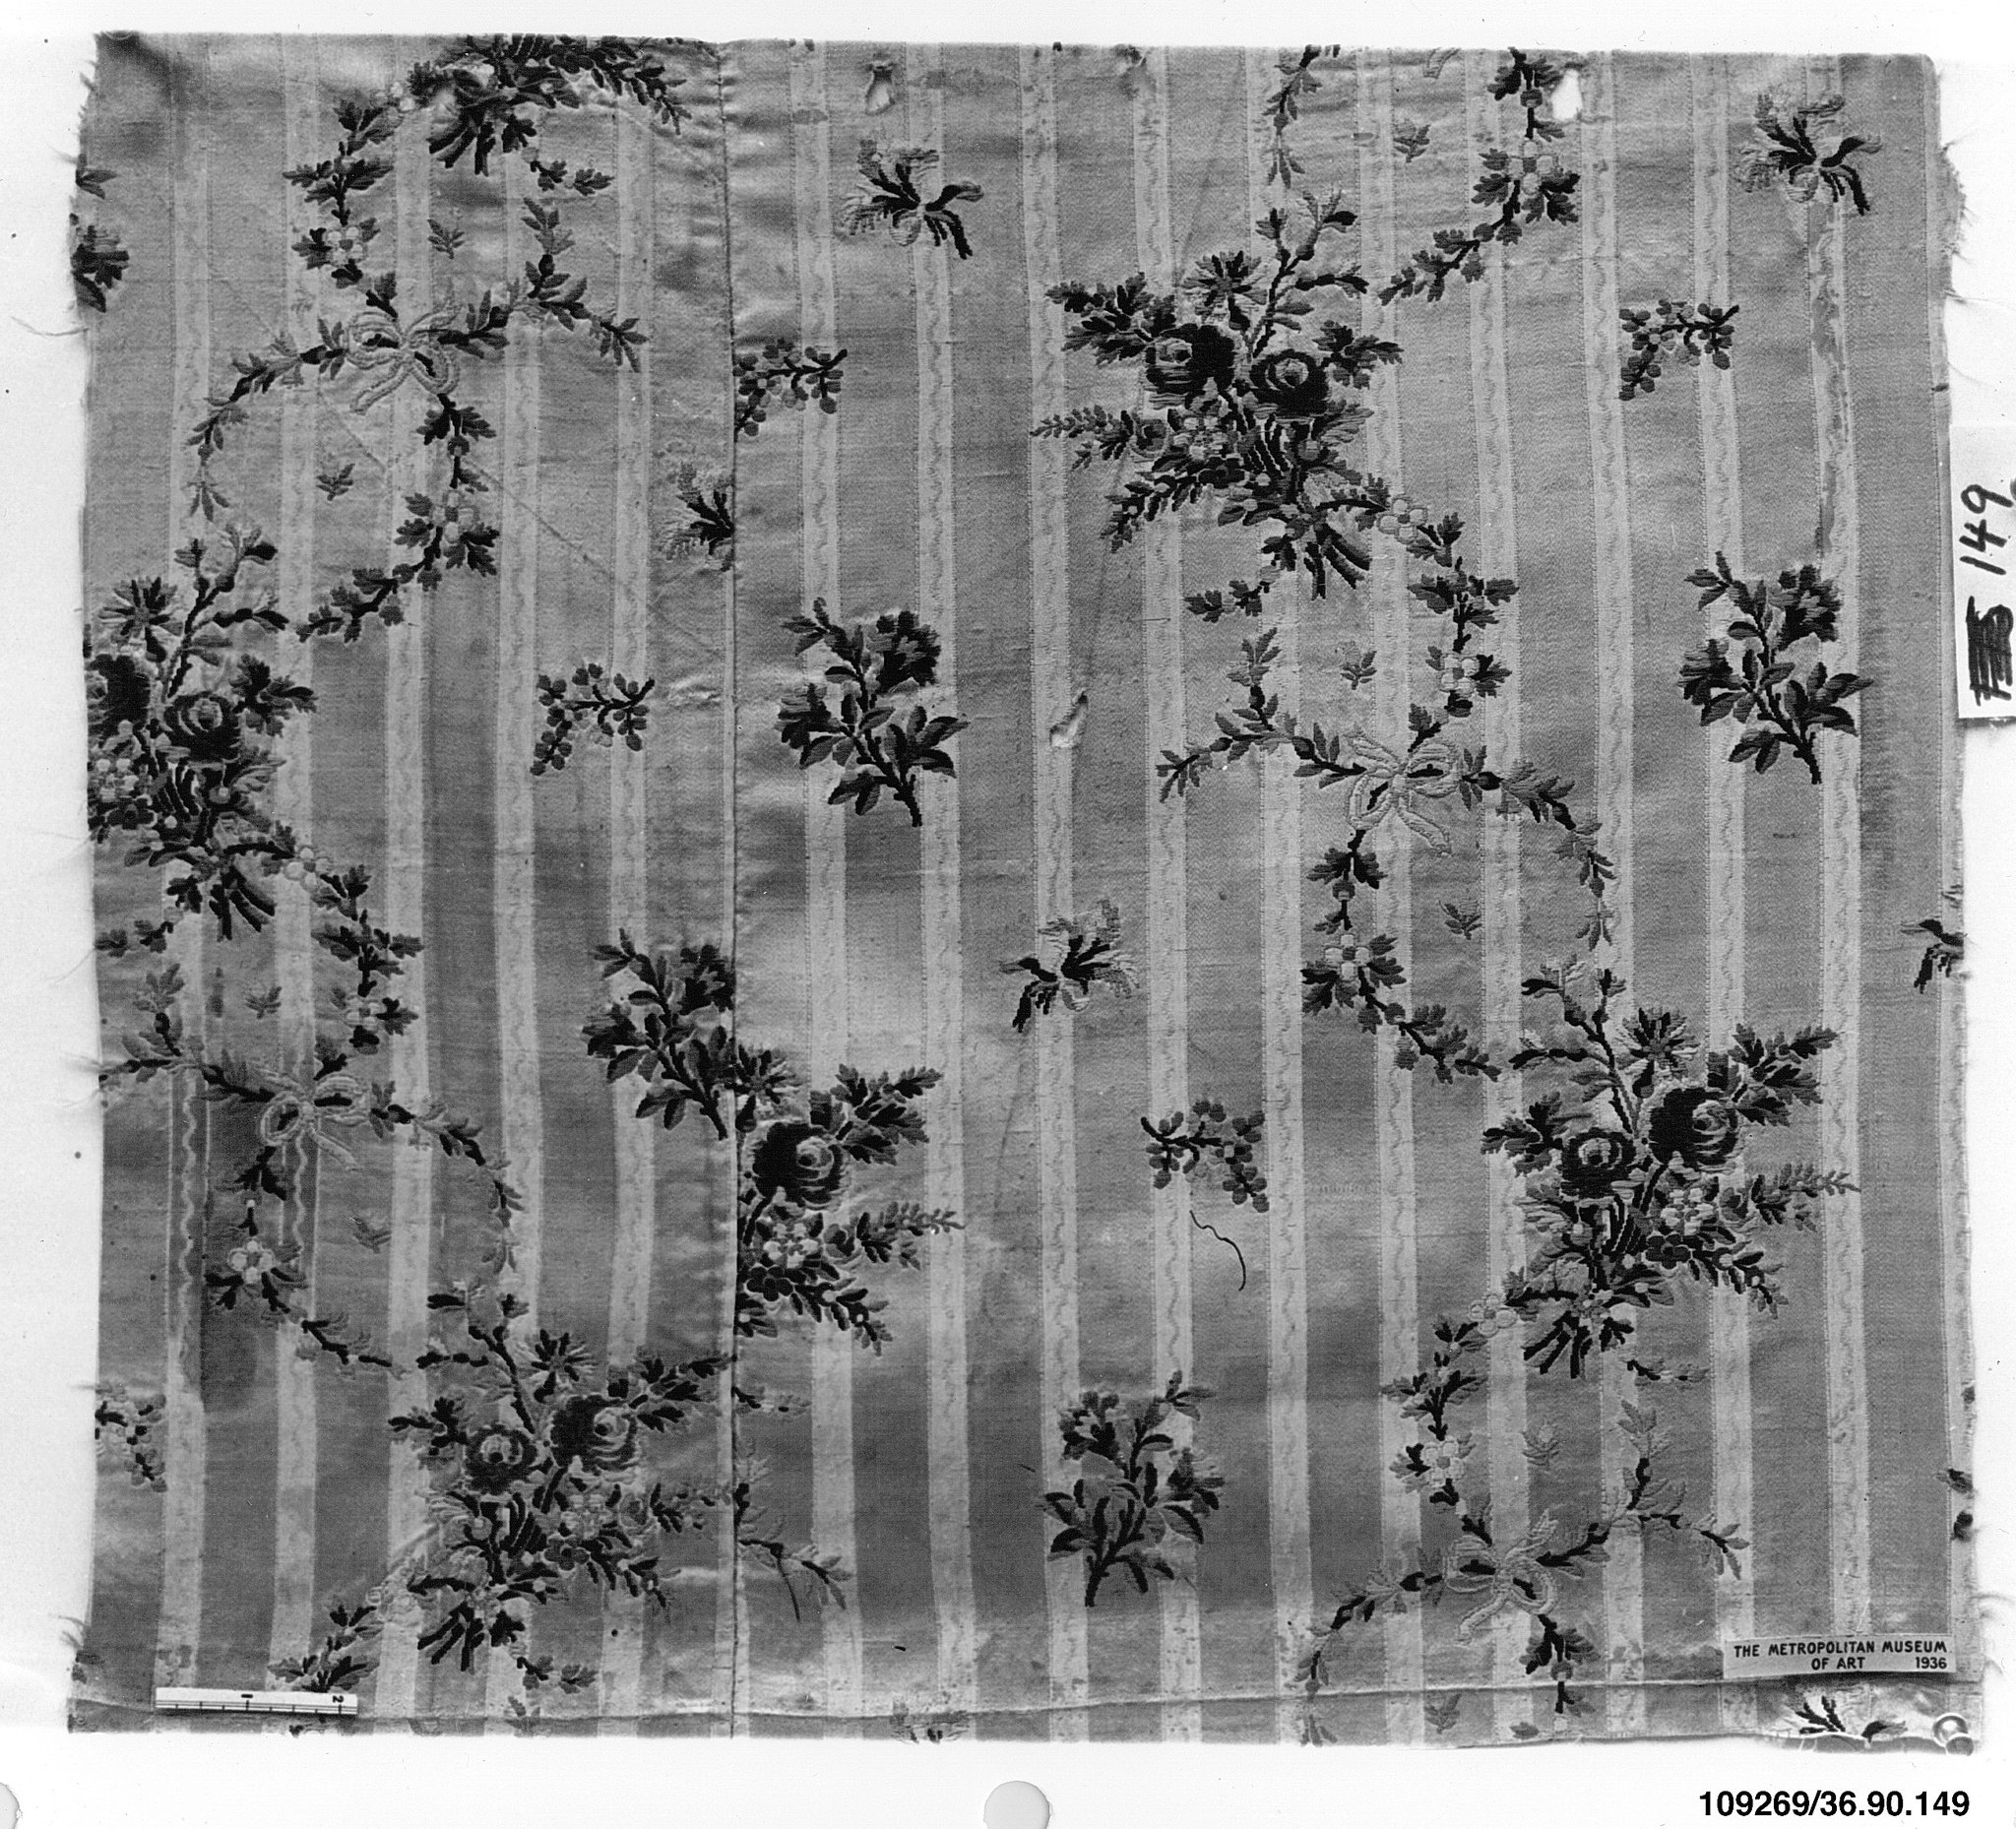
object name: piece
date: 1760-1770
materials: silk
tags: flowers,leaves